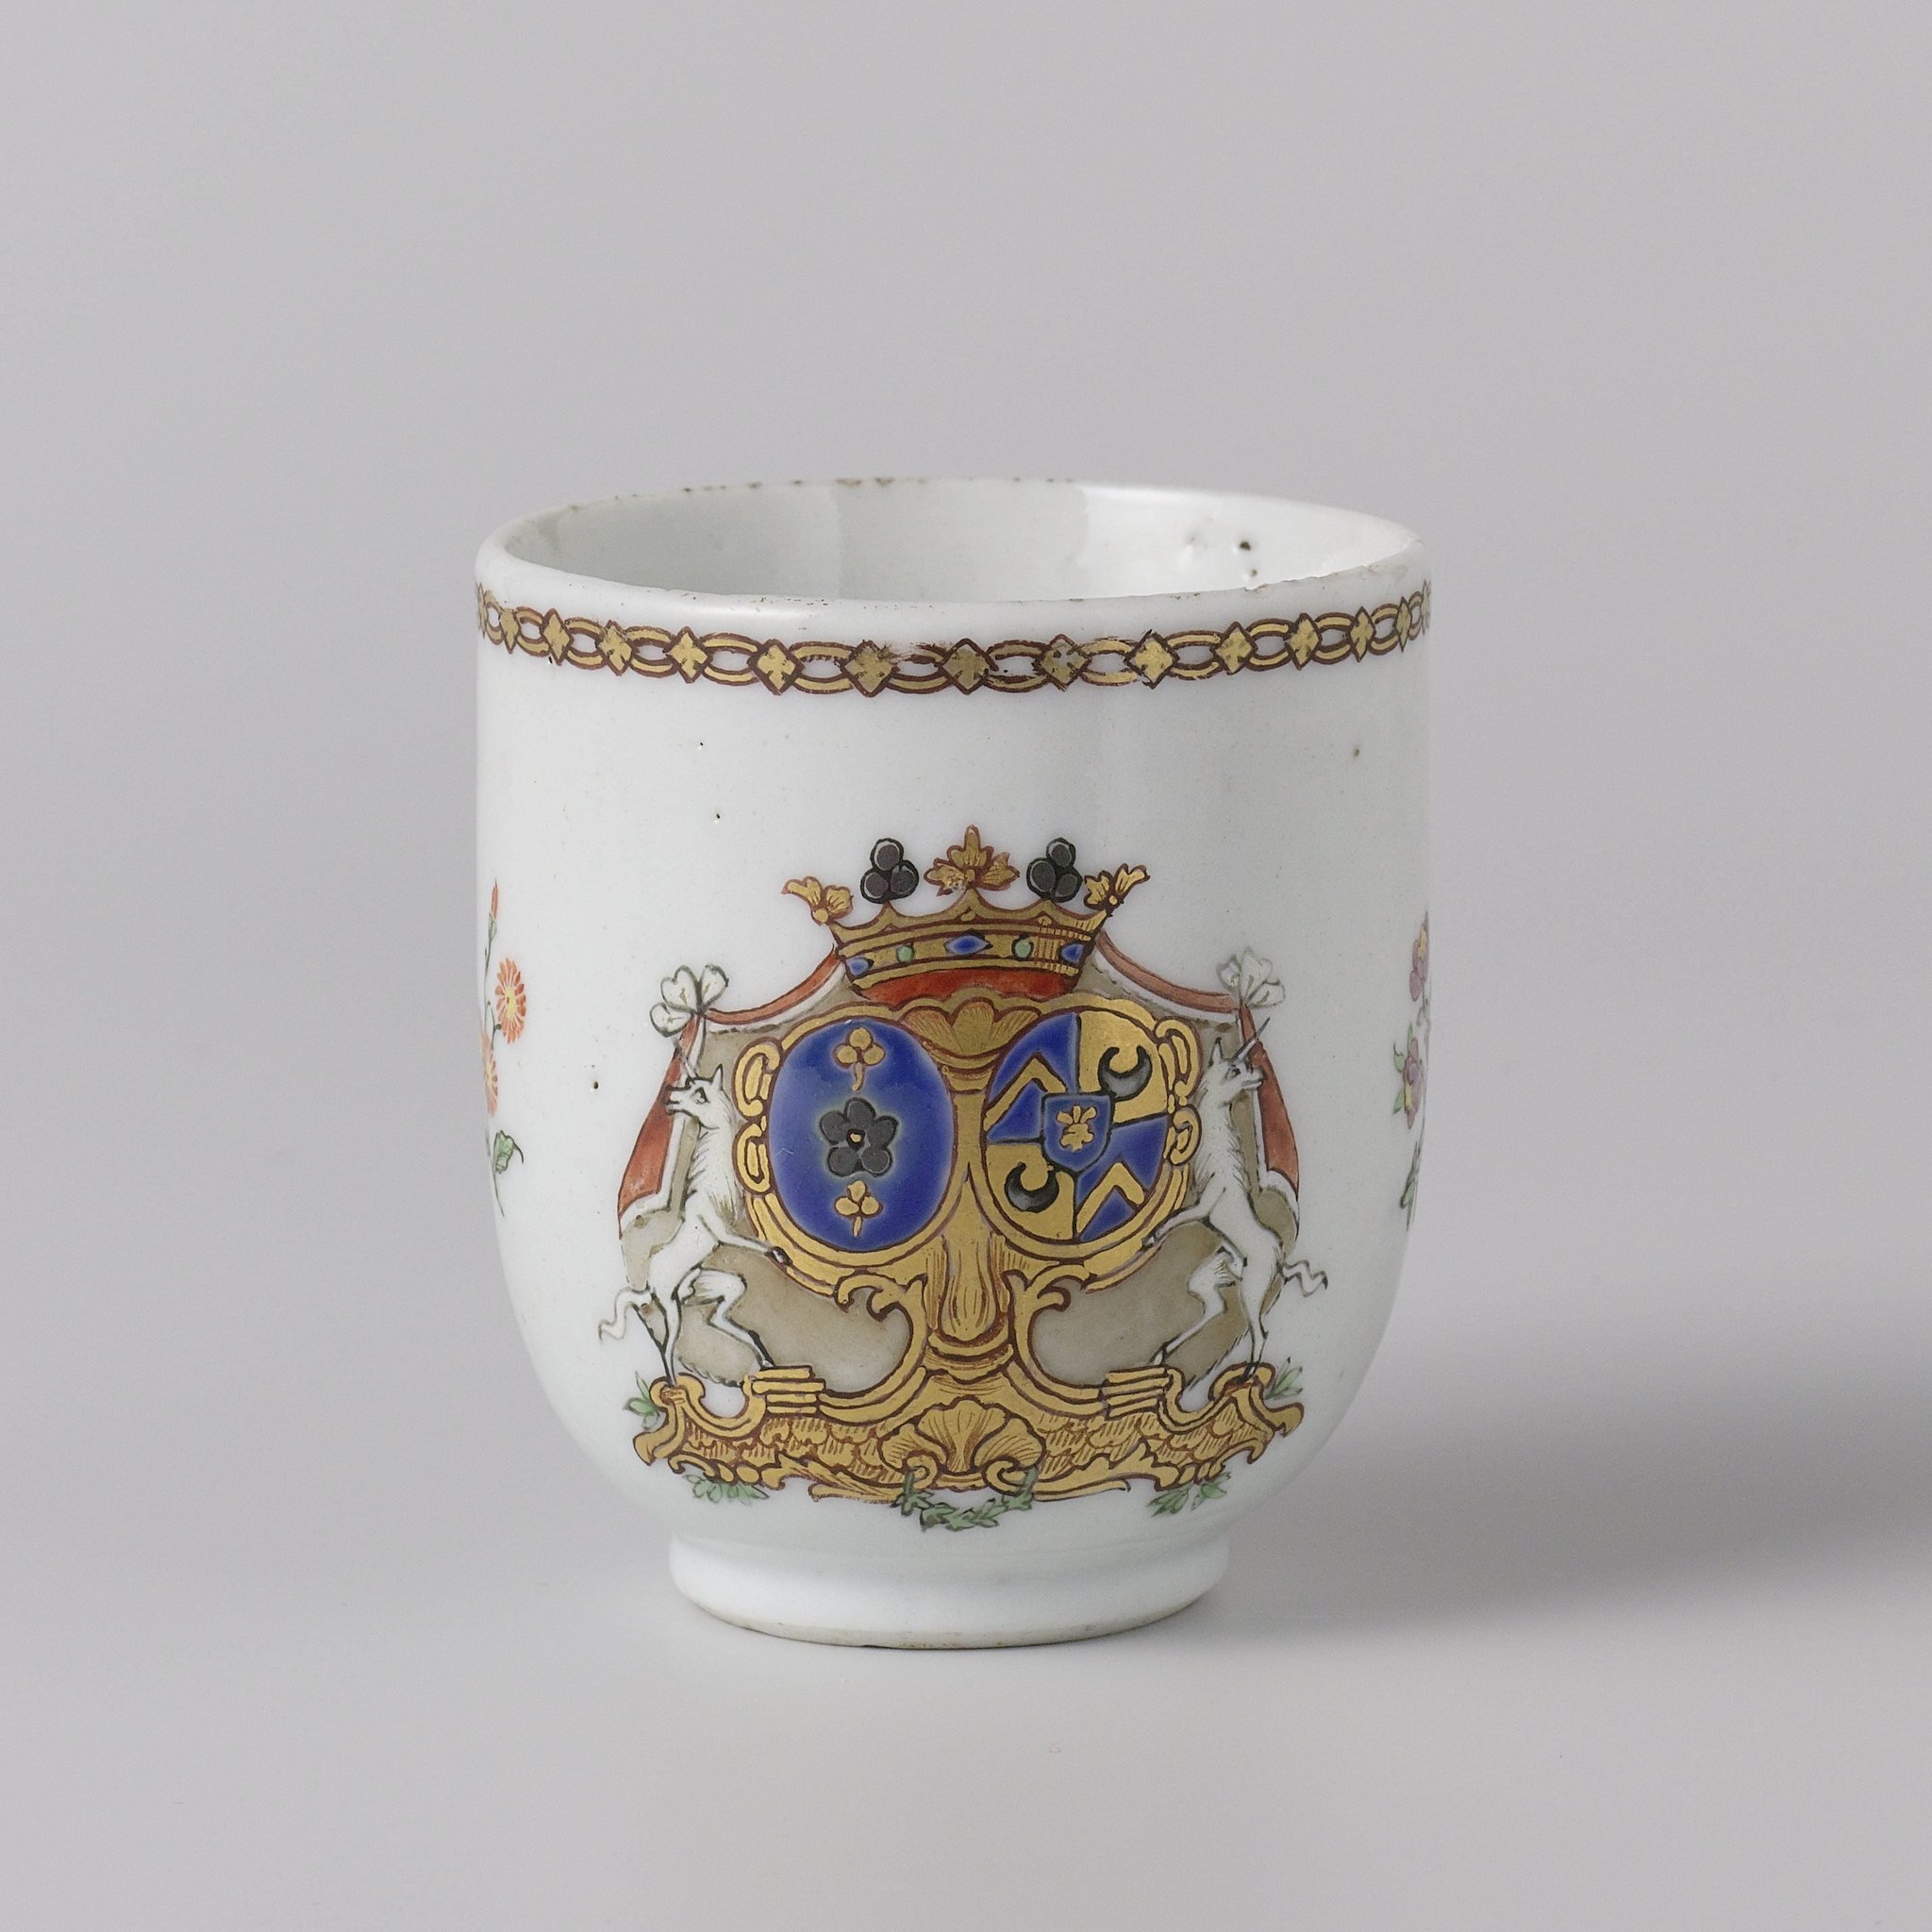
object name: cup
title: Cup with handle with the arms of the Van Idsinga and Kien families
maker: Anonymous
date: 1750-1774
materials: glaze, gold, paint, porcelain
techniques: firing, gilding, turning, vitrification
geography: china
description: Oorkop van porselein, beschilderd op het glazuur in blauw, rood, roze, groen, geel, paars, zwart en goud. Op de wand het alliantiewapen van de families Van Idsinga en Kien. Het wapen links van de familie Van Idsinga heeft een blauwe achtergrond met een zilveren roos of bloem en een paar gouden klavers. Het wapen rechts van de familie Kien is verdeeld in vier delen: 1. en 4. een blauwe achtergrond met een gouden keper, 2. en 3. een gouden achtergrond met een zwarte maan. In het midden van het wapen is een hartschild met een blauwe achtergrond en een gouden fleur-de-lis. Bovenop de wapens is een kroon afgebeeld. De wapens zijn afgebeeld op een gouden cartouche met schelp- en bladwerk in Louis XIV-stijl. Daarachter een hermelijnen mantel in rood en wit. Het geheel wordt ondersteund door twee eenhoorns die staan op een voetstuk. Op de wand strooibloemen; de rand met een schakelpatroon. Wapenporselein met emailkleuren.